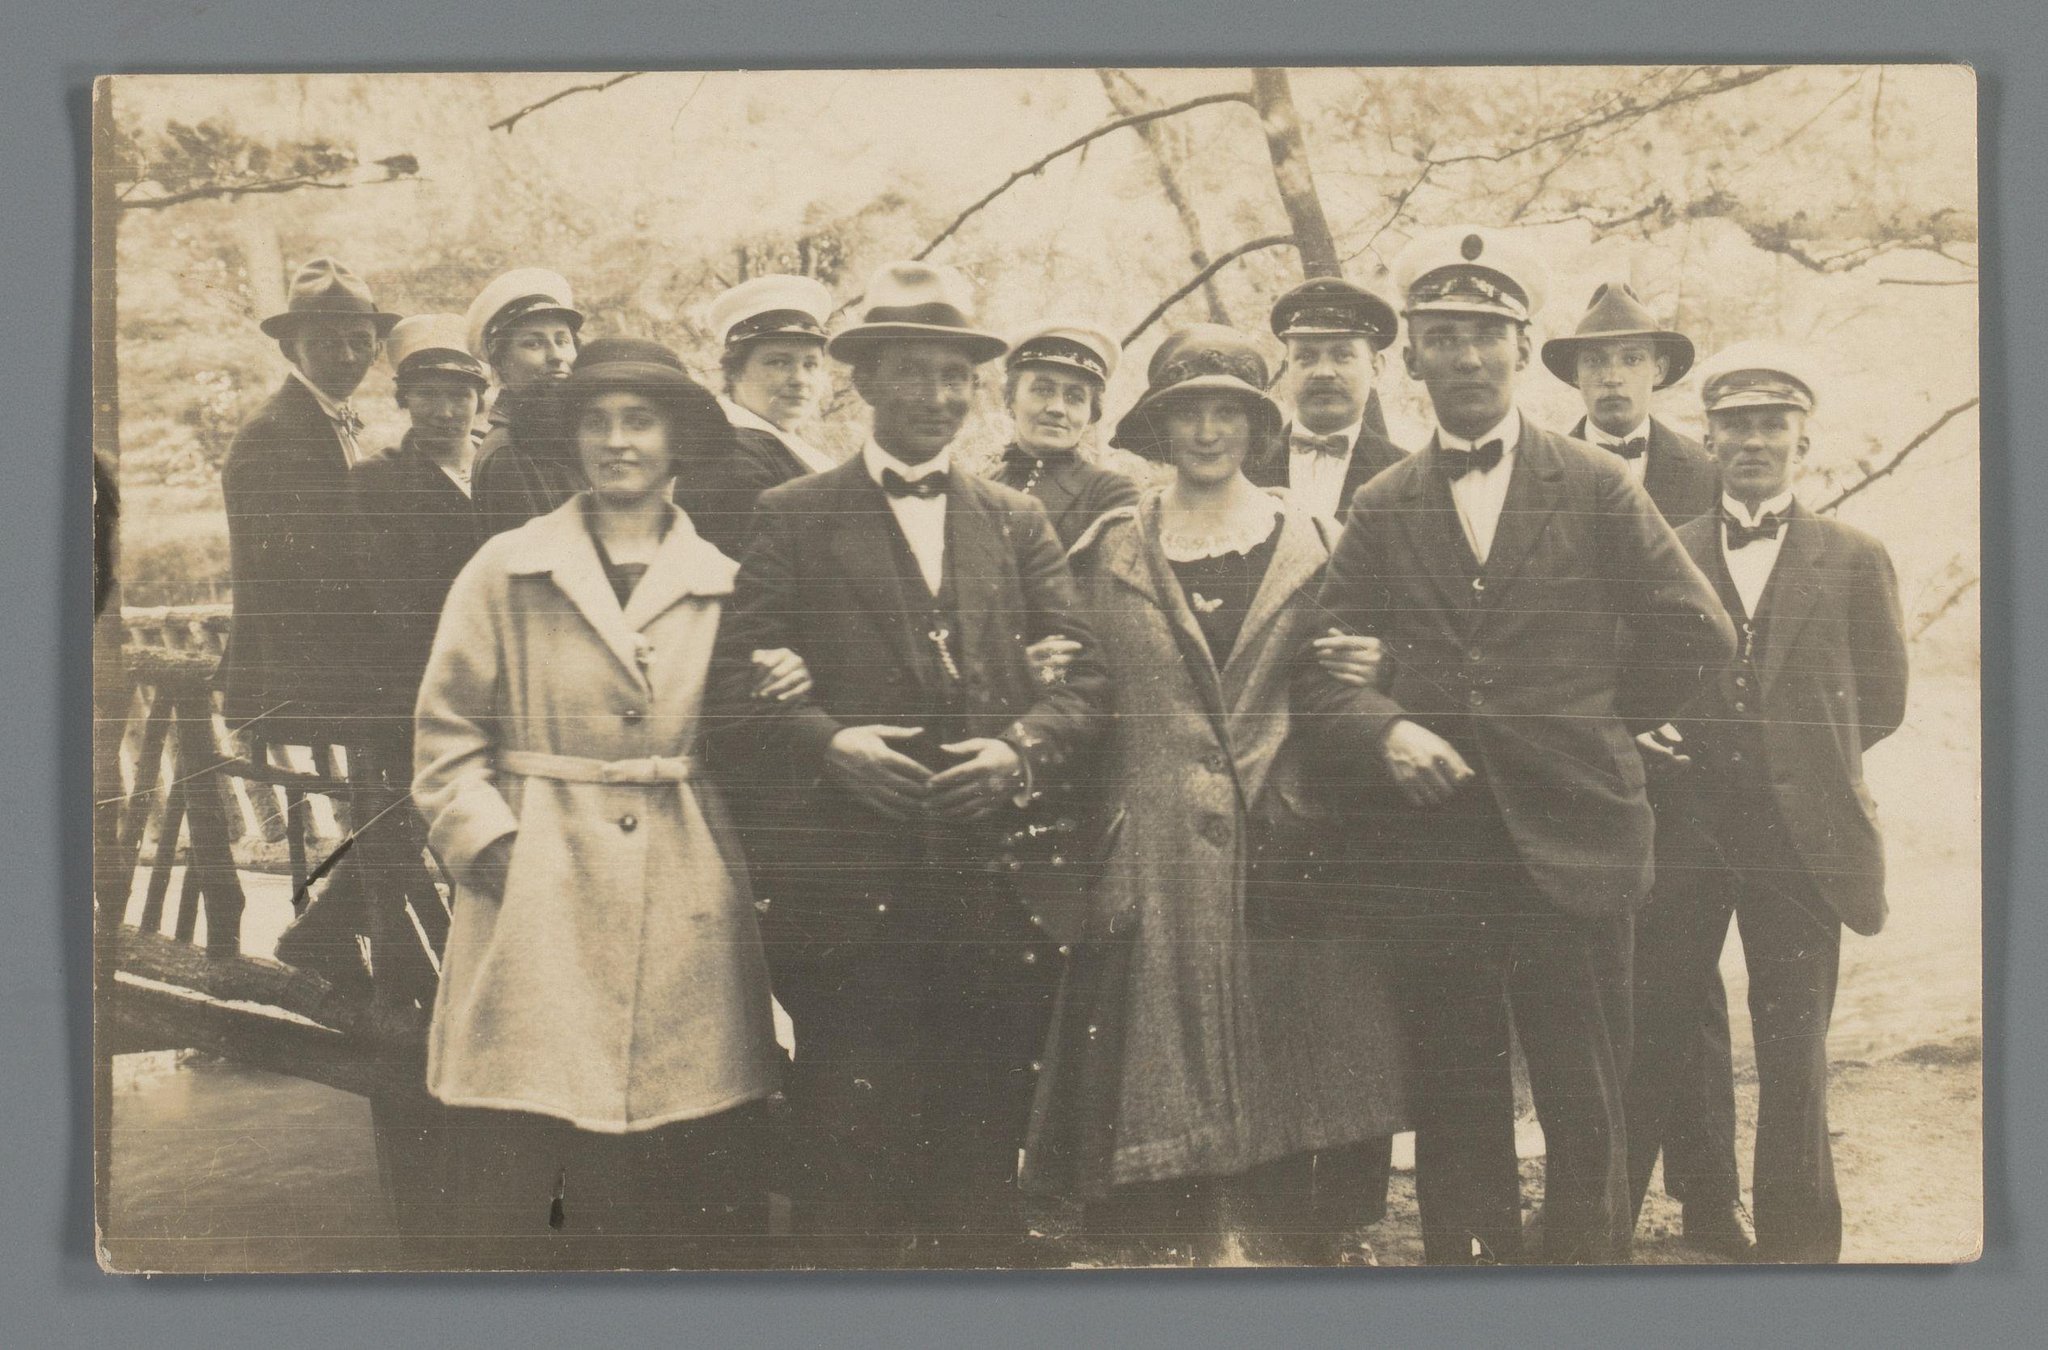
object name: photograph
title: Groepsportret van een groep onbekende jongeren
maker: Anonymous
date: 1905-1920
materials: paper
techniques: gelatin silver print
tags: arm in arm (friends), anonymous historical persons portrayed in a group, in a group-portrait